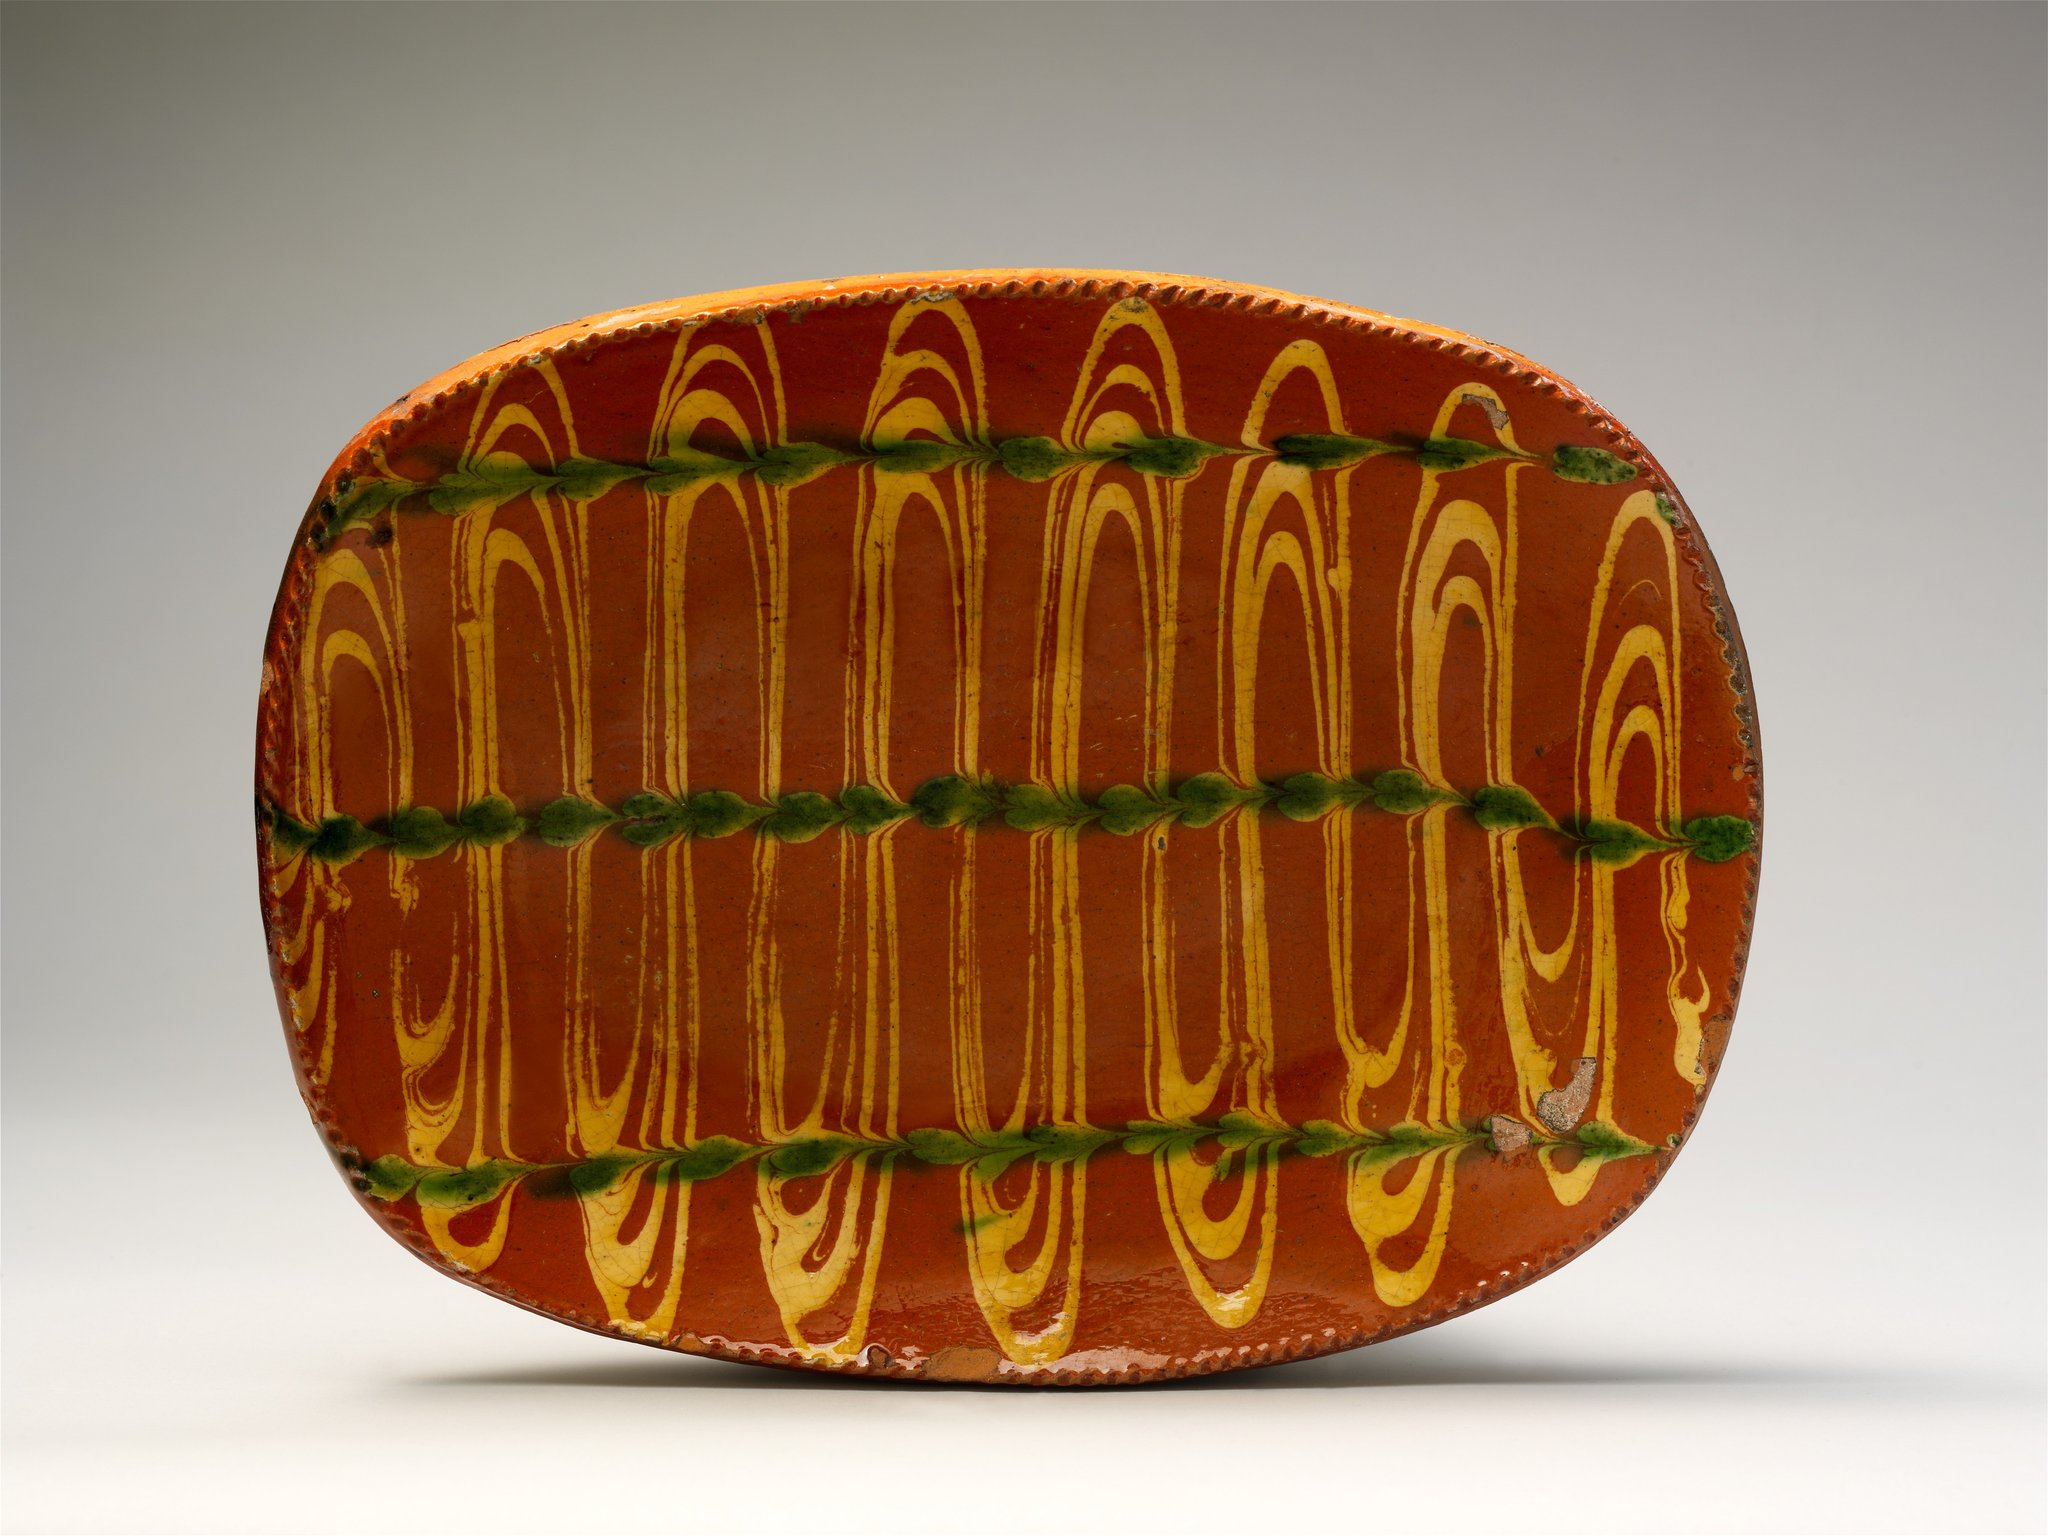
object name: plate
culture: american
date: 1850-1875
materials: earthenware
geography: united states